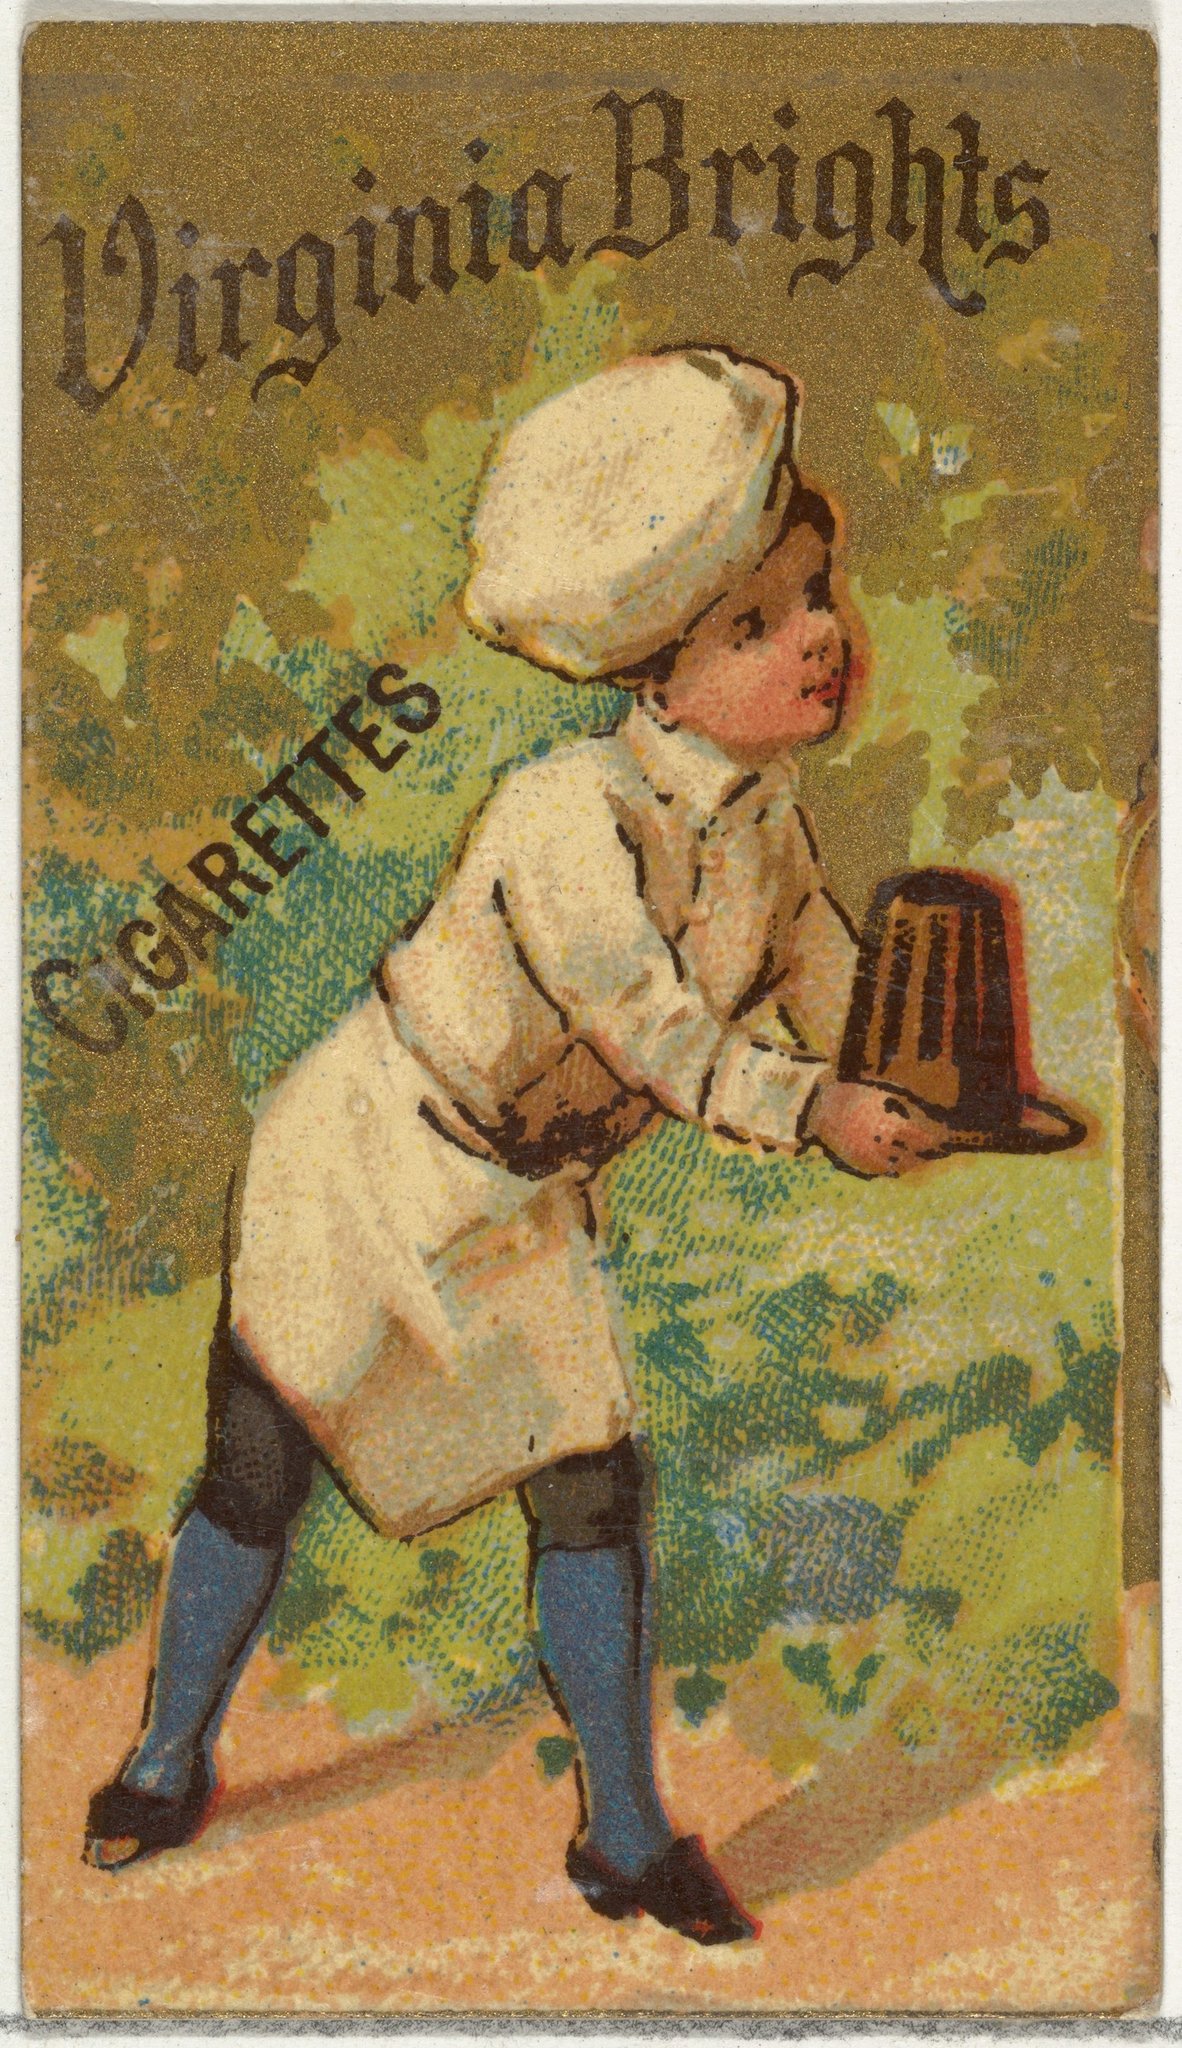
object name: print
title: From the Girls and Children series (N64) promoting Virginia Brights Cigarettes for Allen & Ginter brand tobacco products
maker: allen & ginter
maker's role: publisher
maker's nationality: american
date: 1886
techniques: color lithograph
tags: food,children